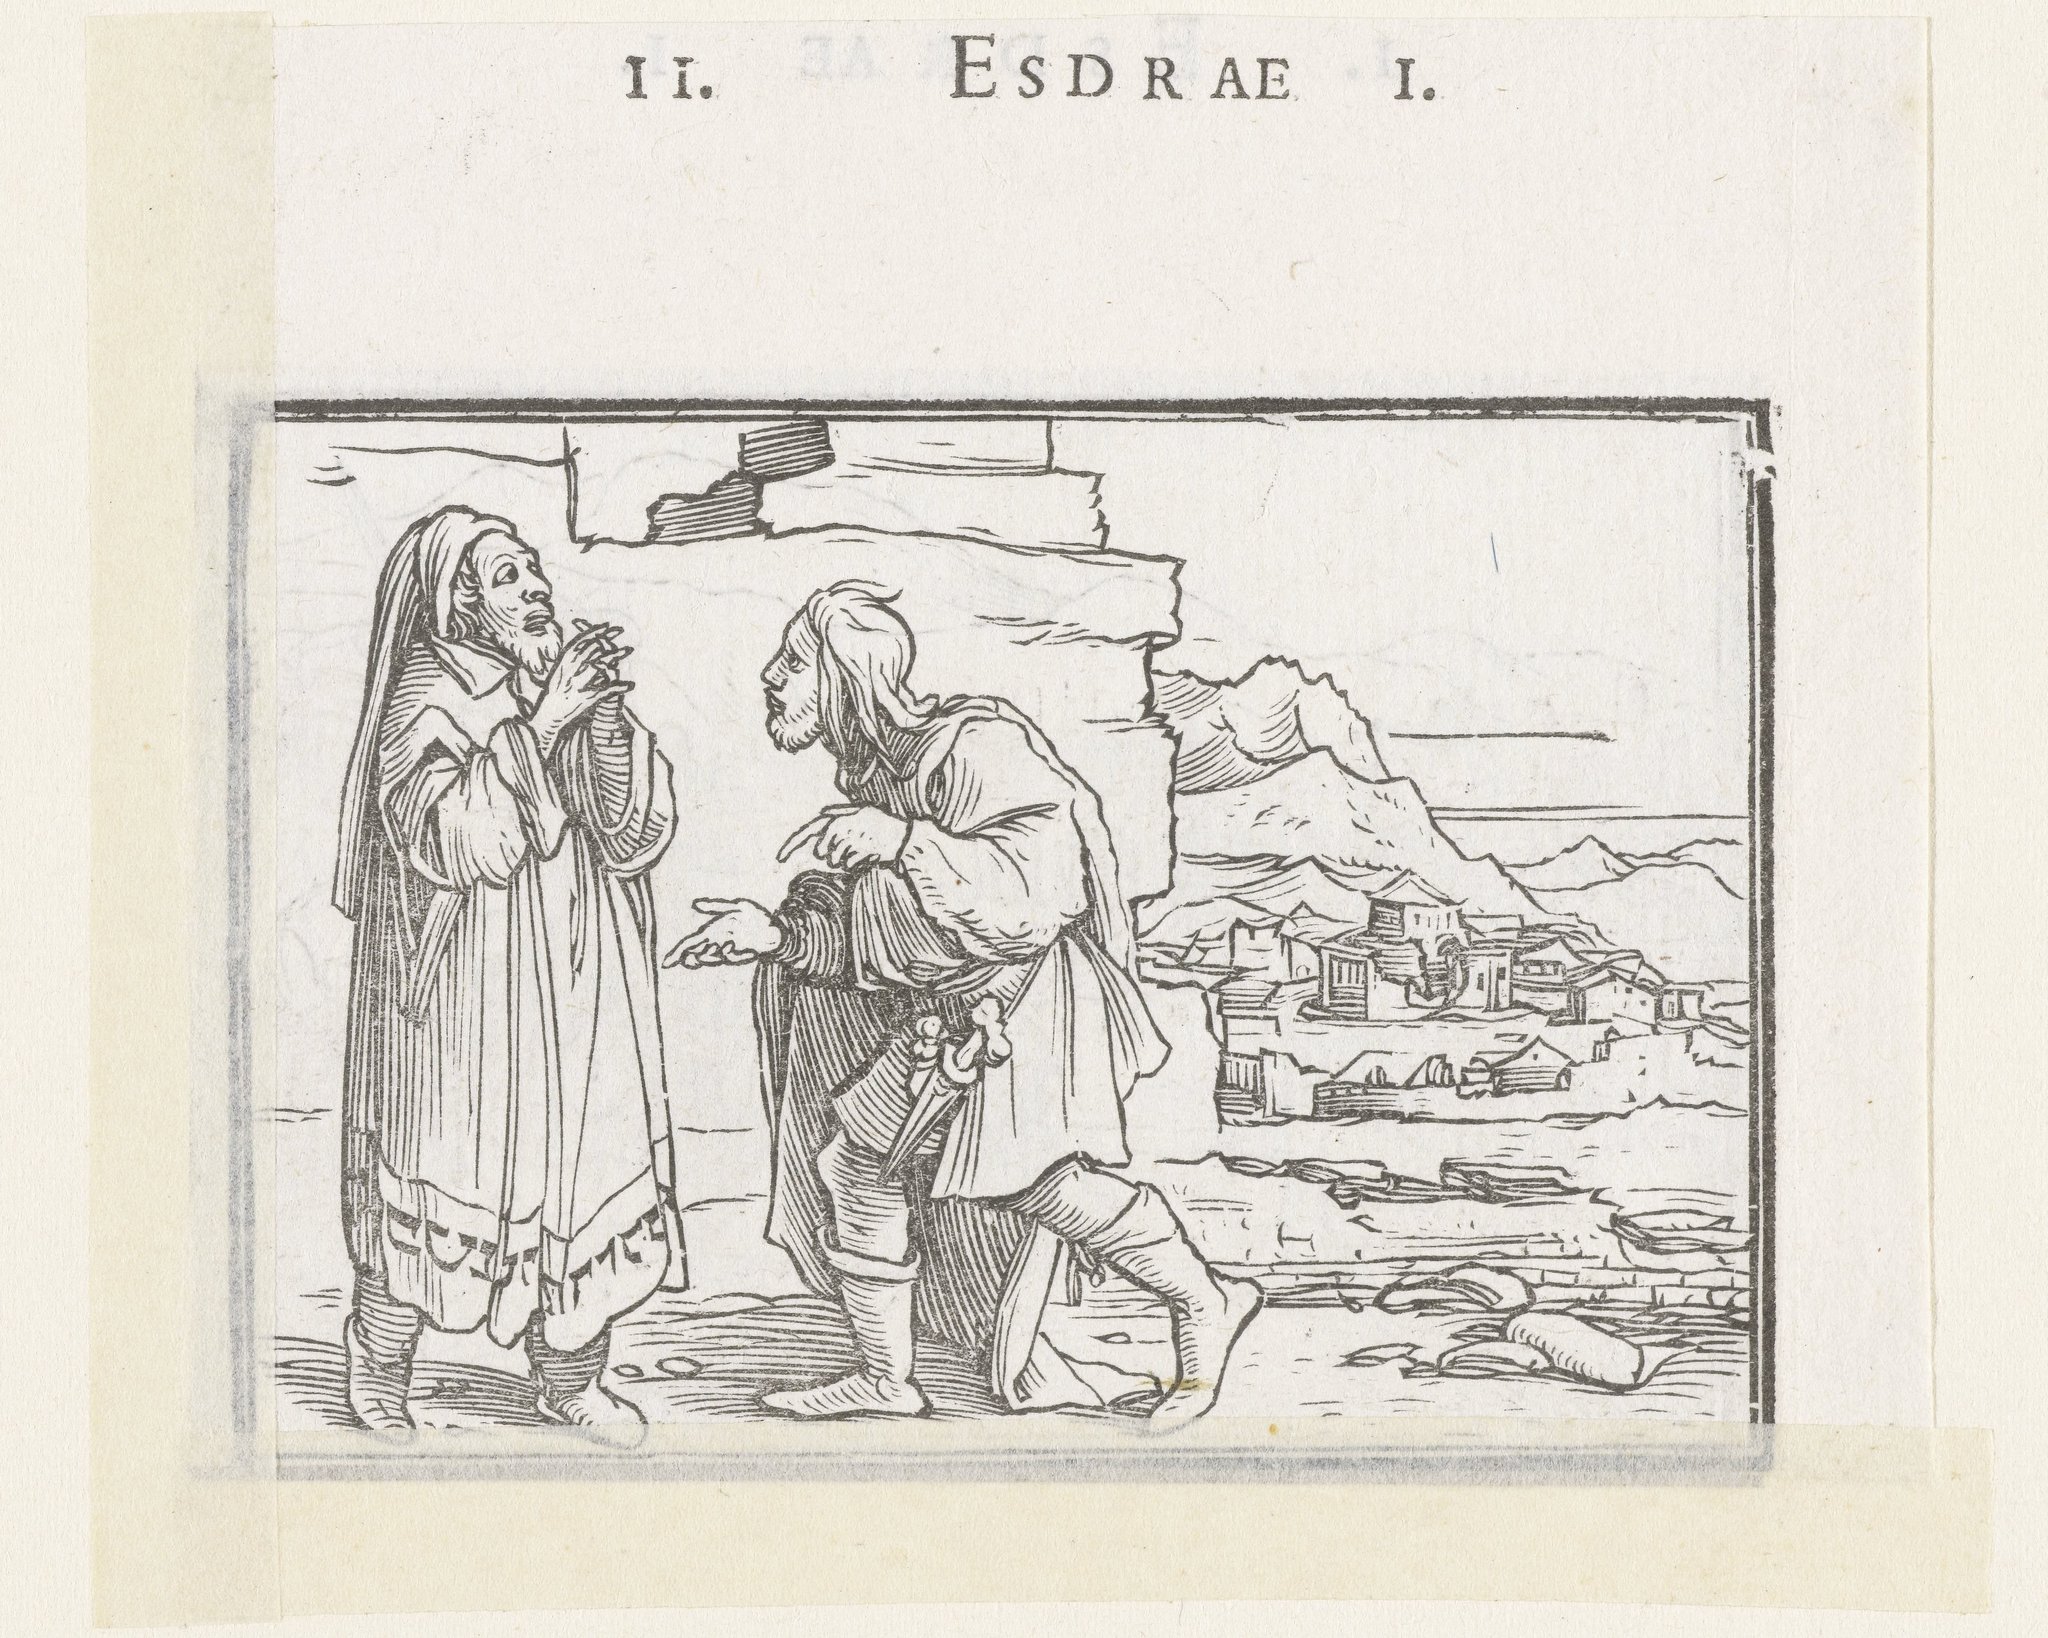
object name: print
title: Nehemia hoort over de slechte toestand in Jeruzalem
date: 1538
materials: paper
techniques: woodcut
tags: nehemiah's return to jerusalem (nehemiah 1 - 2:11)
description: Houtblok voor het eerst gebruikt in: Biblia Utriusque Testamenti iuxta Vulgatam Translationem, Lyon, M. en G. Trechsel (voor Hugo à Porta) 1538. Later in verschillende uitgaven opnieuw gebruikt.